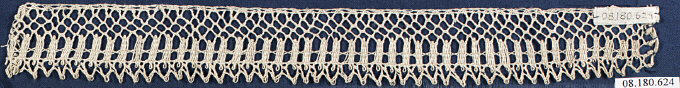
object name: piece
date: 1701-1800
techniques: lace